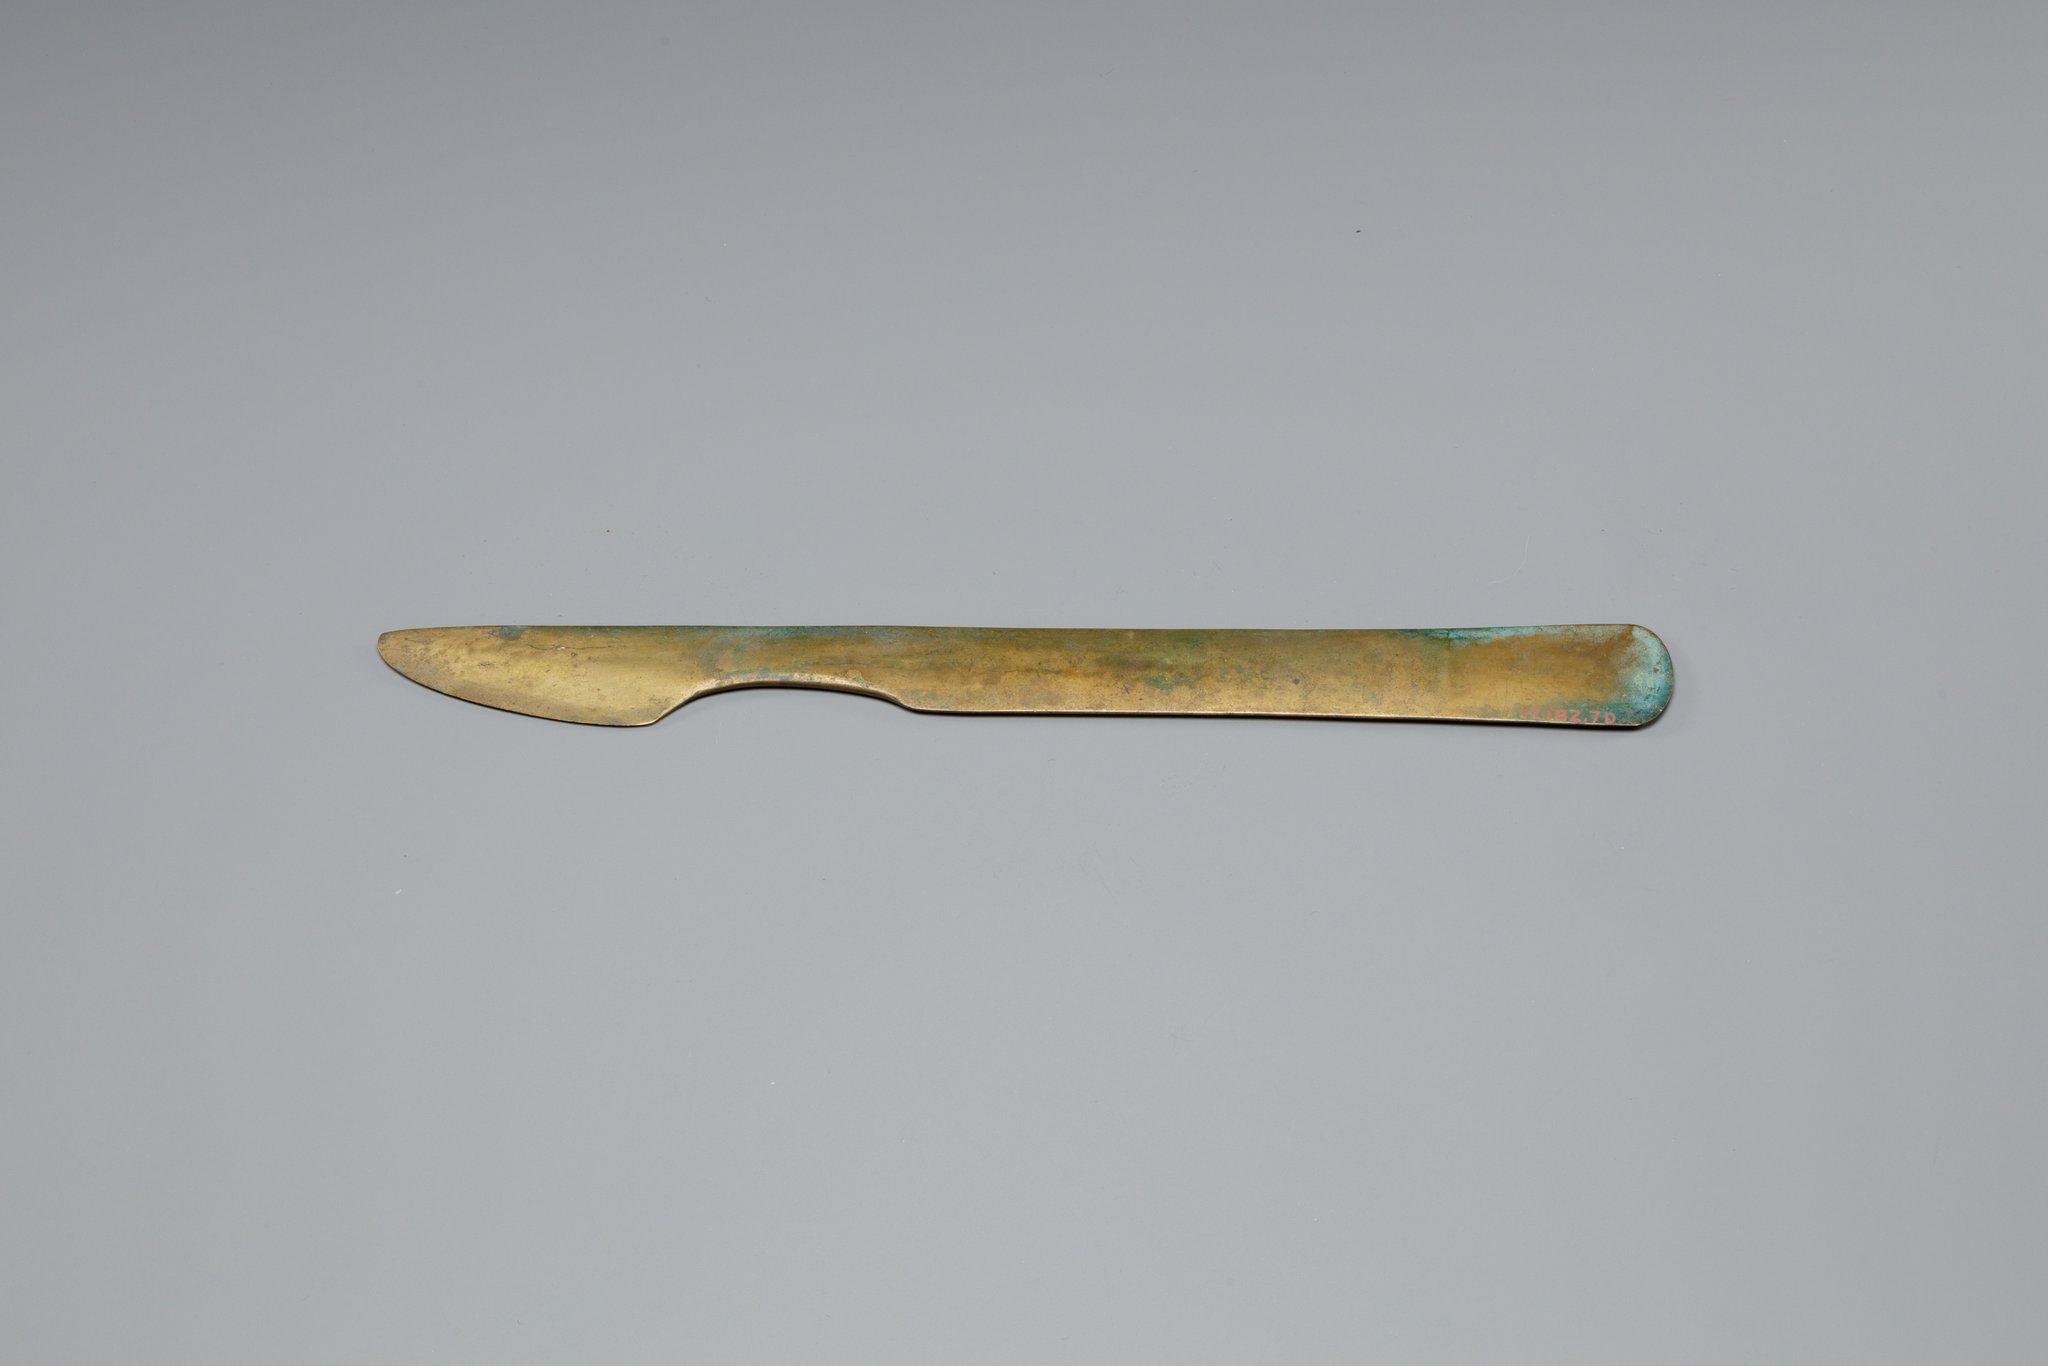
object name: razor knife, dega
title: Knife Razor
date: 1550-1295 BCE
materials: bronze, copper alloy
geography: egypt